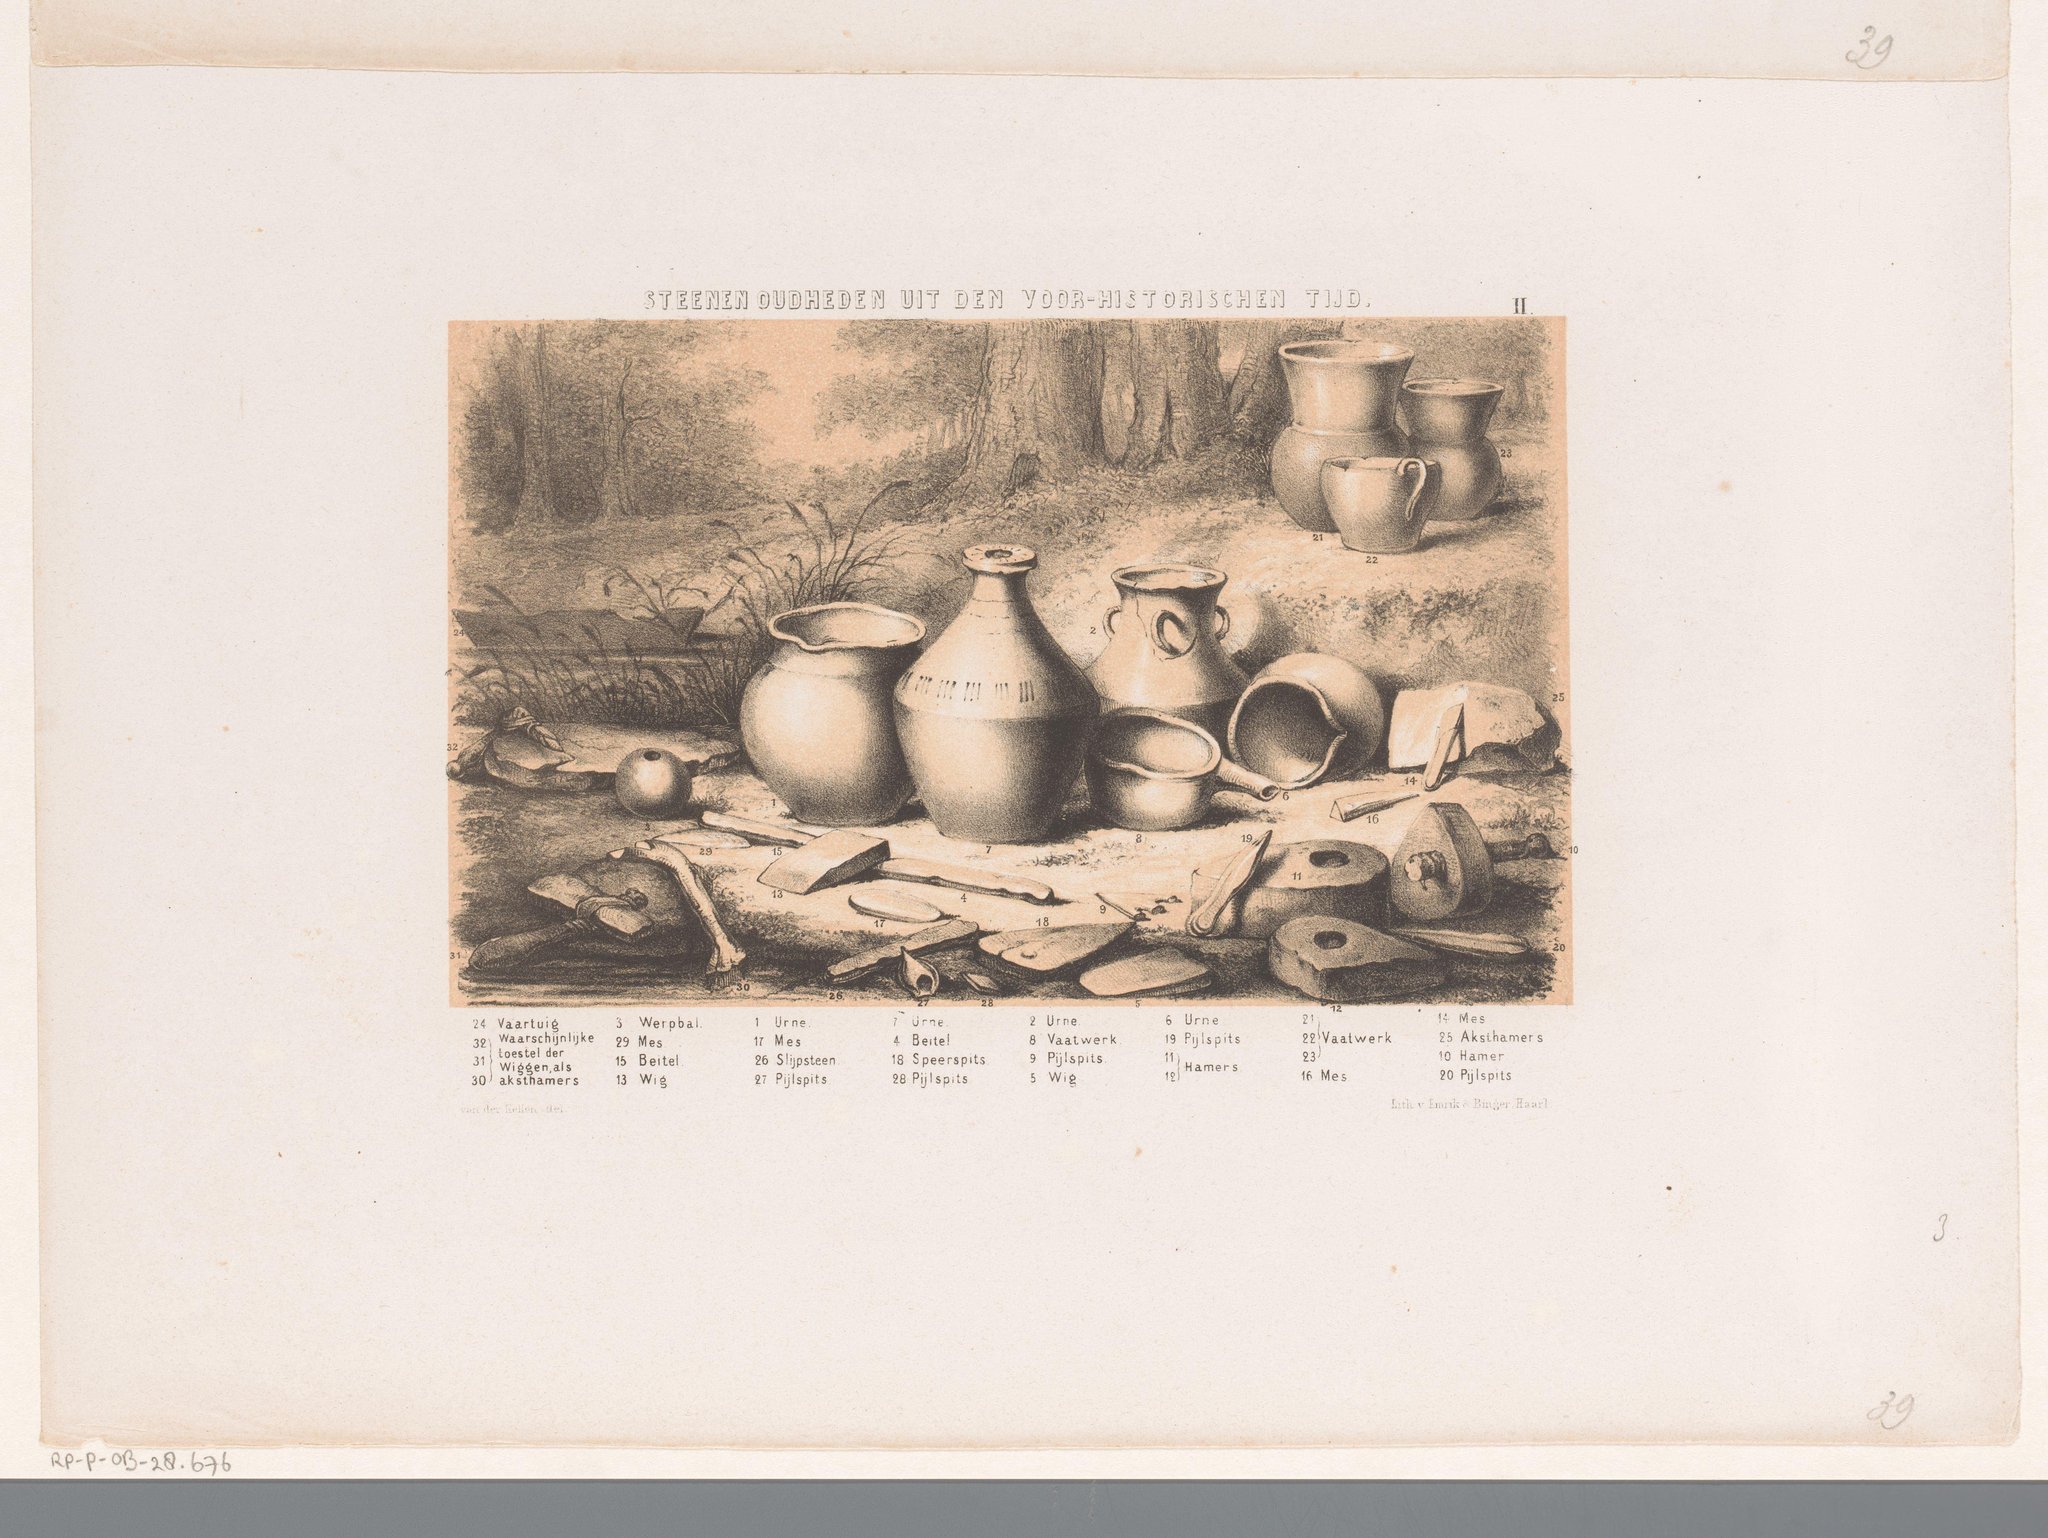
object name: historical object representation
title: Prehistorische artefacten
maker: david van der kellen (1827-1895)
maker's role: draughtsman, print maker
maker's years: 1827-1895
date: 1857-1864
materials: paper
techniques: tone lithography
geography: haarlem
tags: netherlands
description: Illustratie voor: W.J. Hofdijk, Ons voorgeslacht in zijn dagelyksch leven geschilderd, Kruseman, Haarlem 1859-1864.